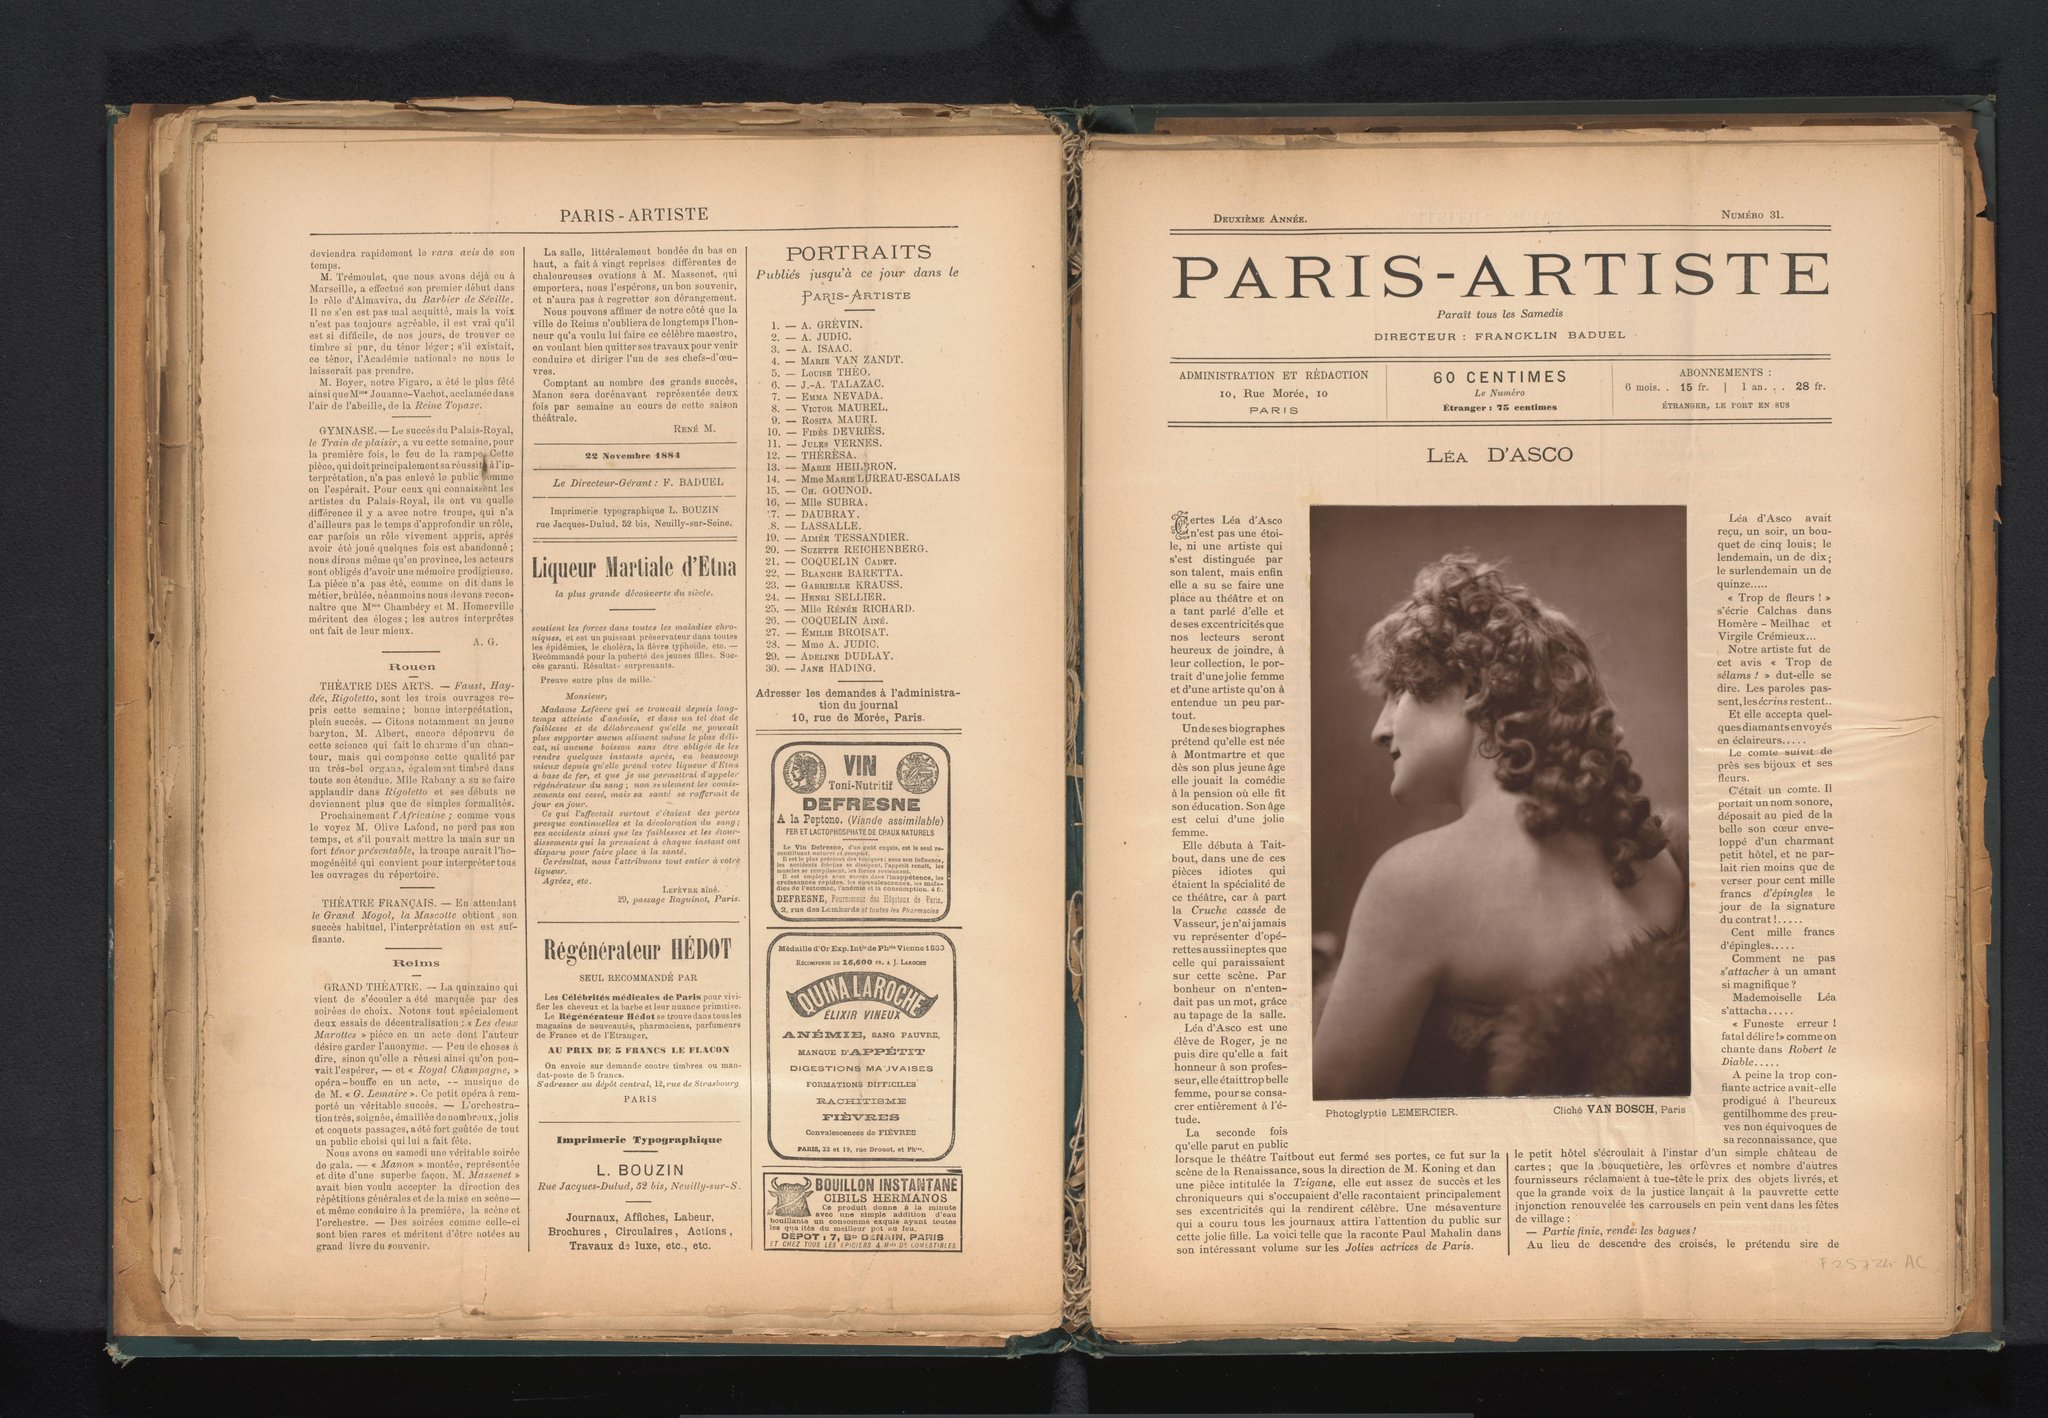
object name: page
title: Portret van Léa d'Asco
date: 1875-1884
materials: paper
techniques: woodburytype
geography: paris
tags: historical persons - bb - woman, portrait of actor, actress